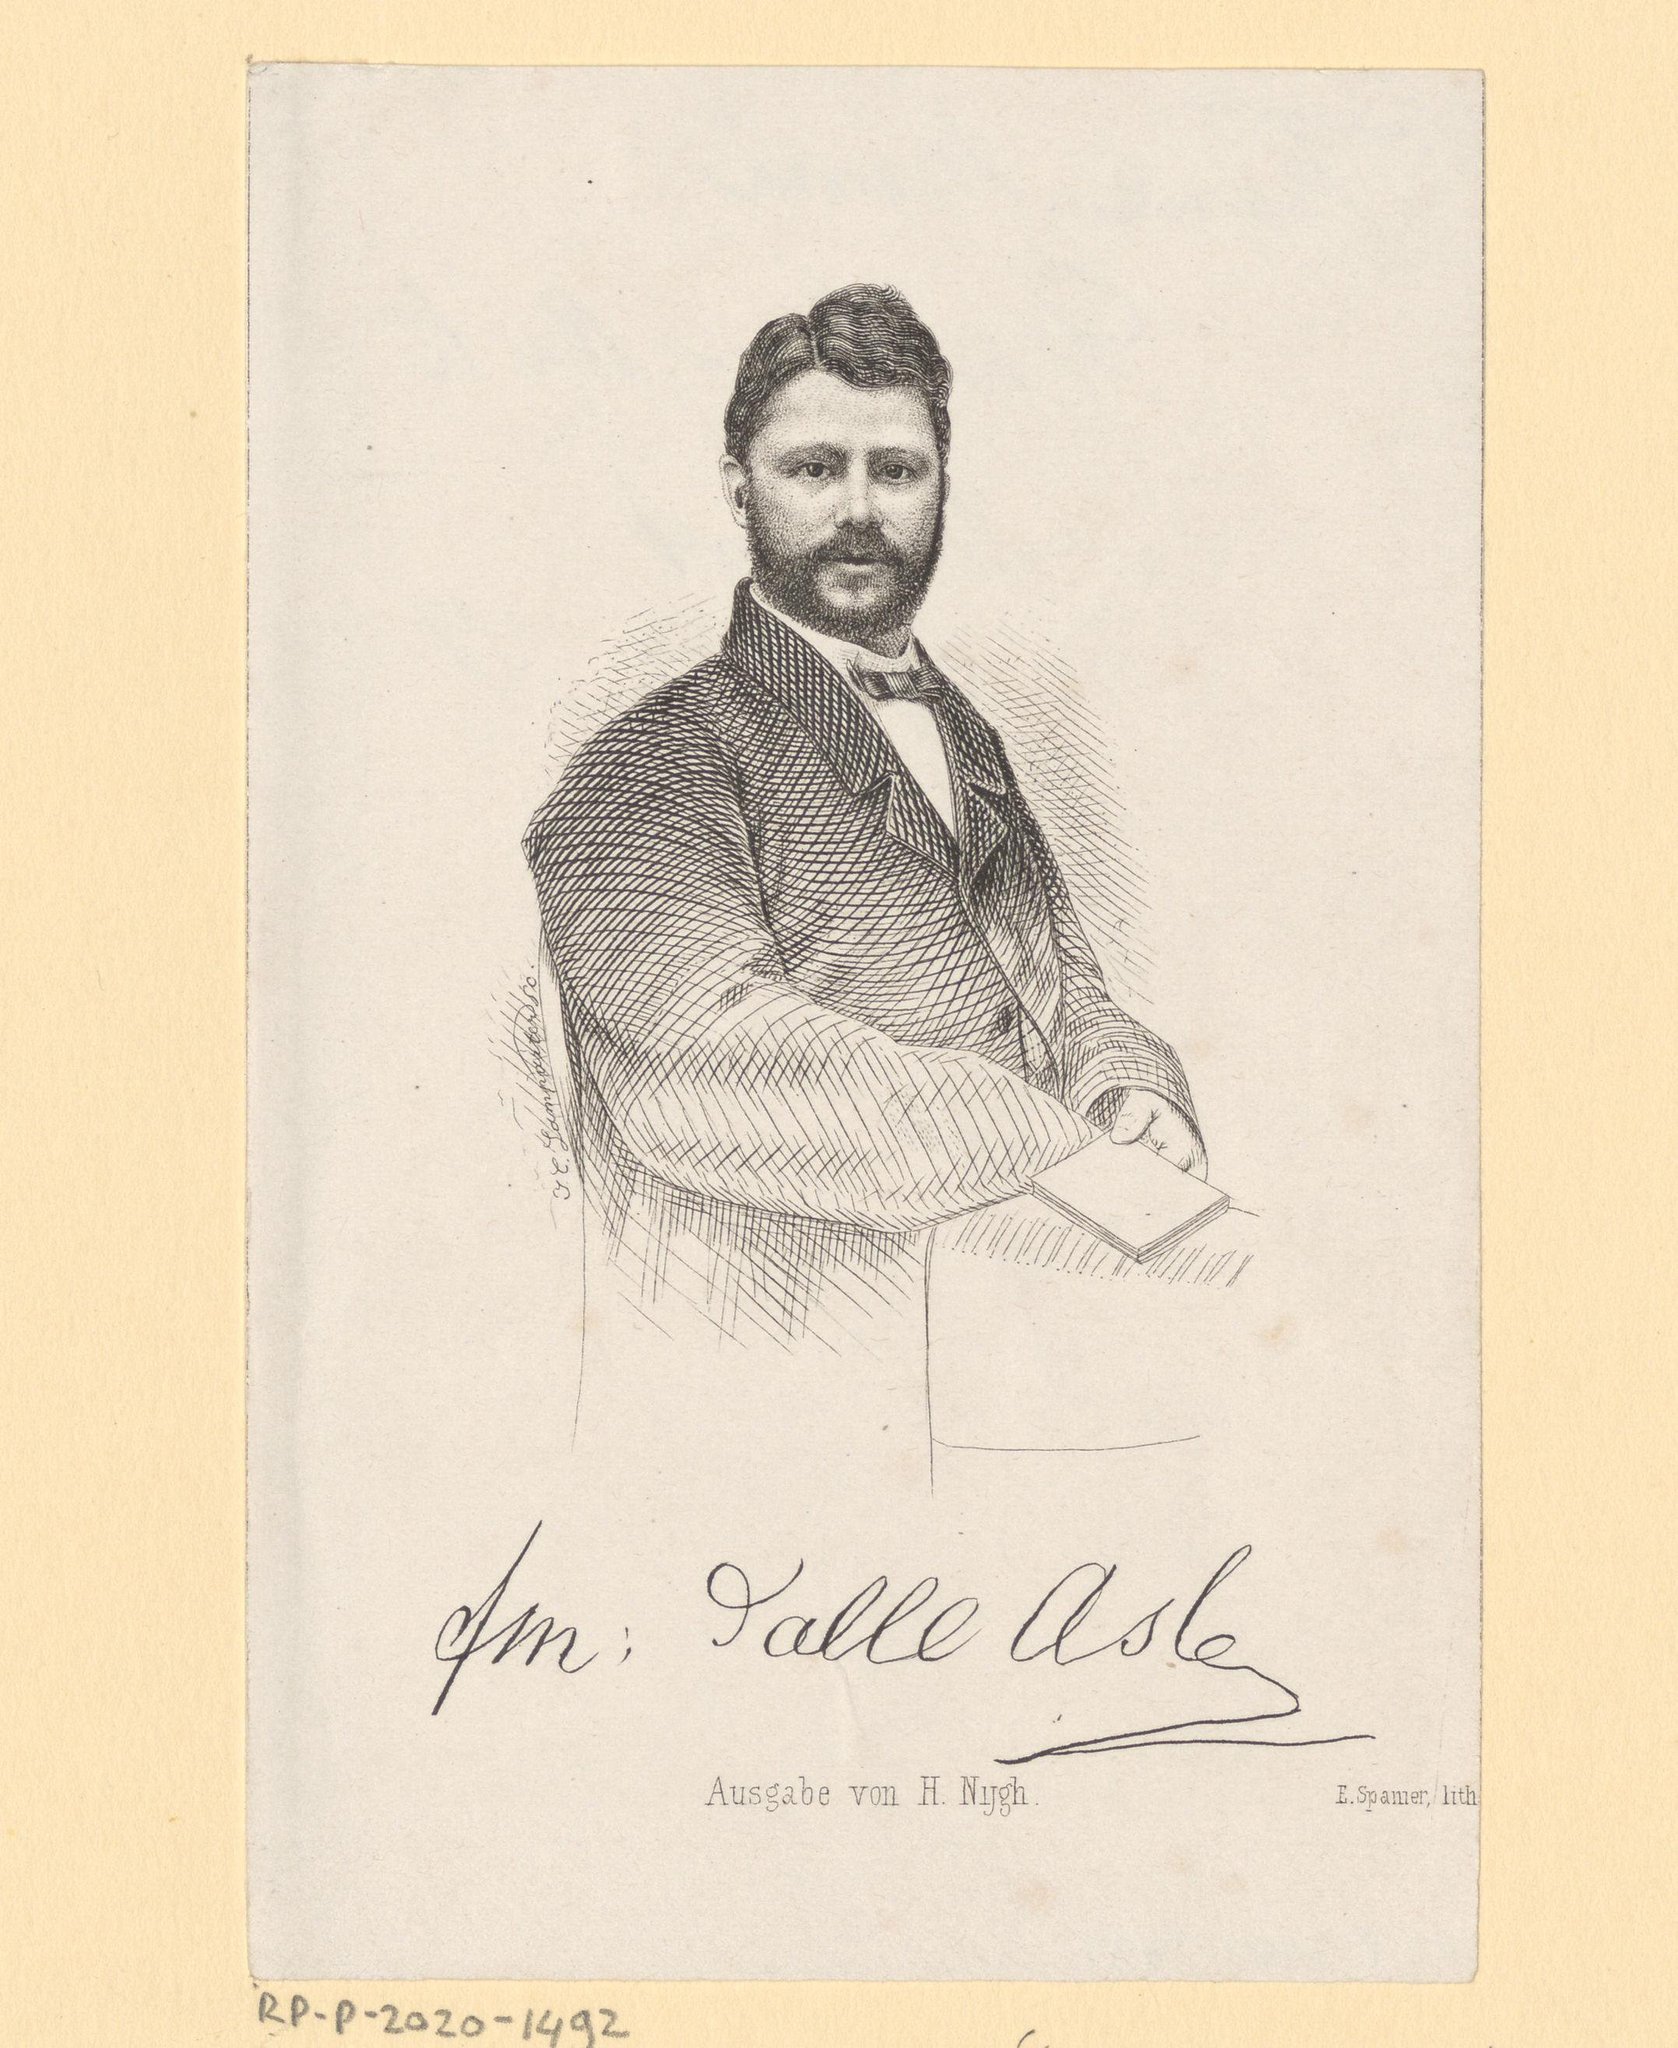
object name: print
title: Portret van Franz Maria Dalle Aste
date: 1843-1863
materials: paper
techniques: lithograph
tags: historical persons, portrait of opera-singer